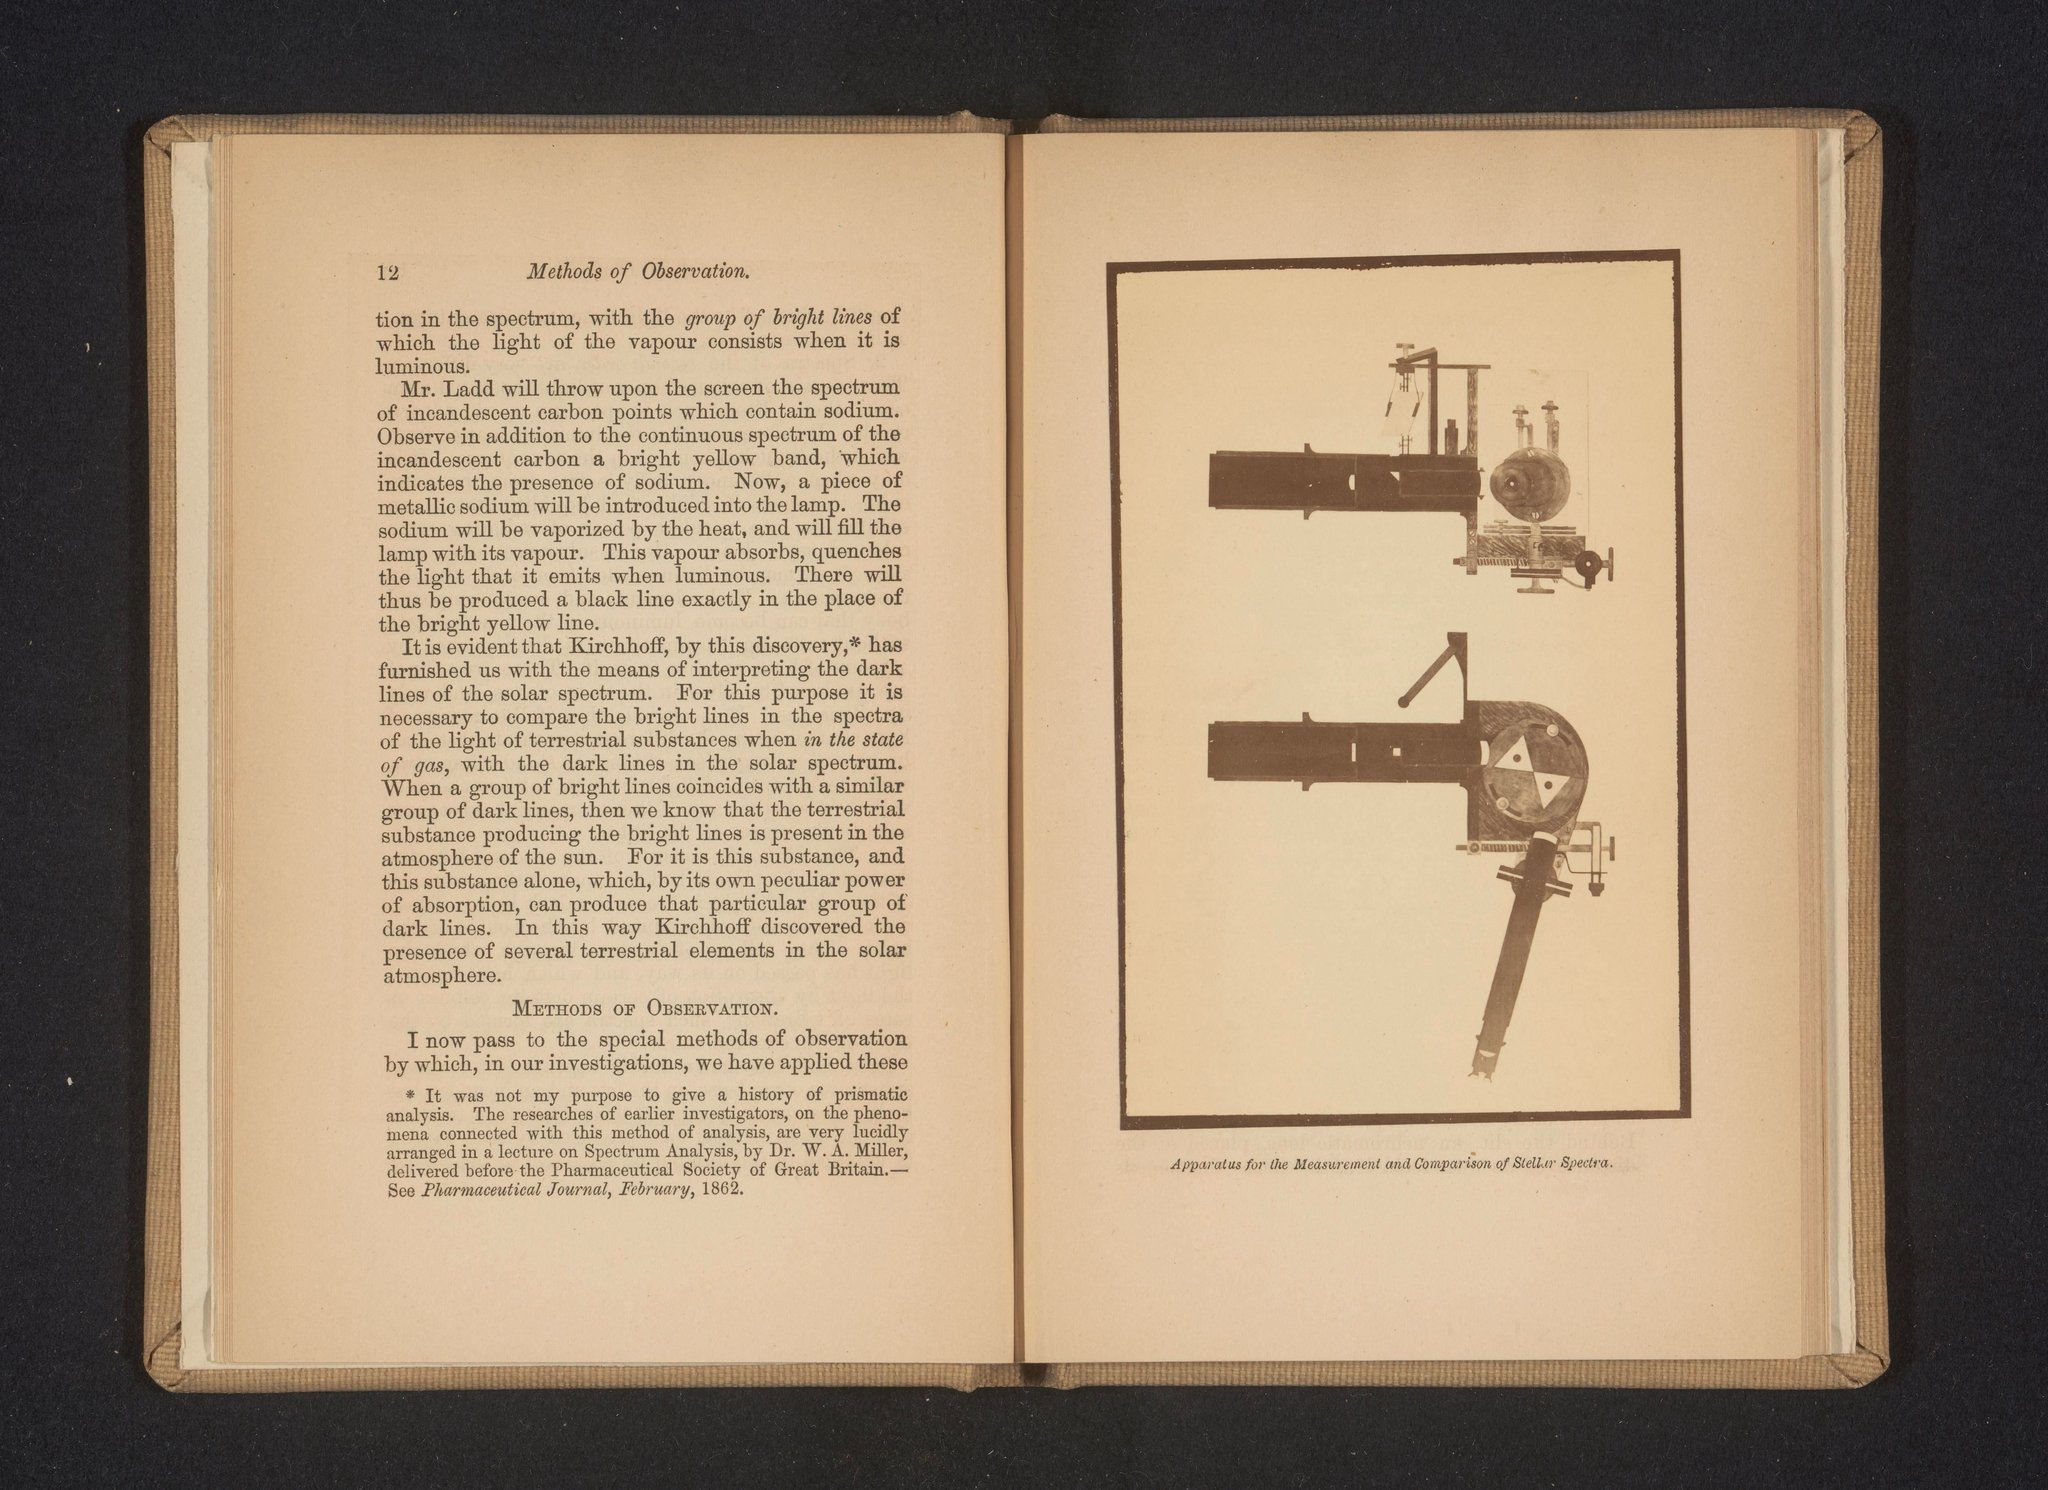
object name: photograph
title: Twee apparaten om spectra van sterren te meten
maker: Anonymous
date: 1856-1866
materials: photographic support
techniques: albumen print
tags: measuring-instruments